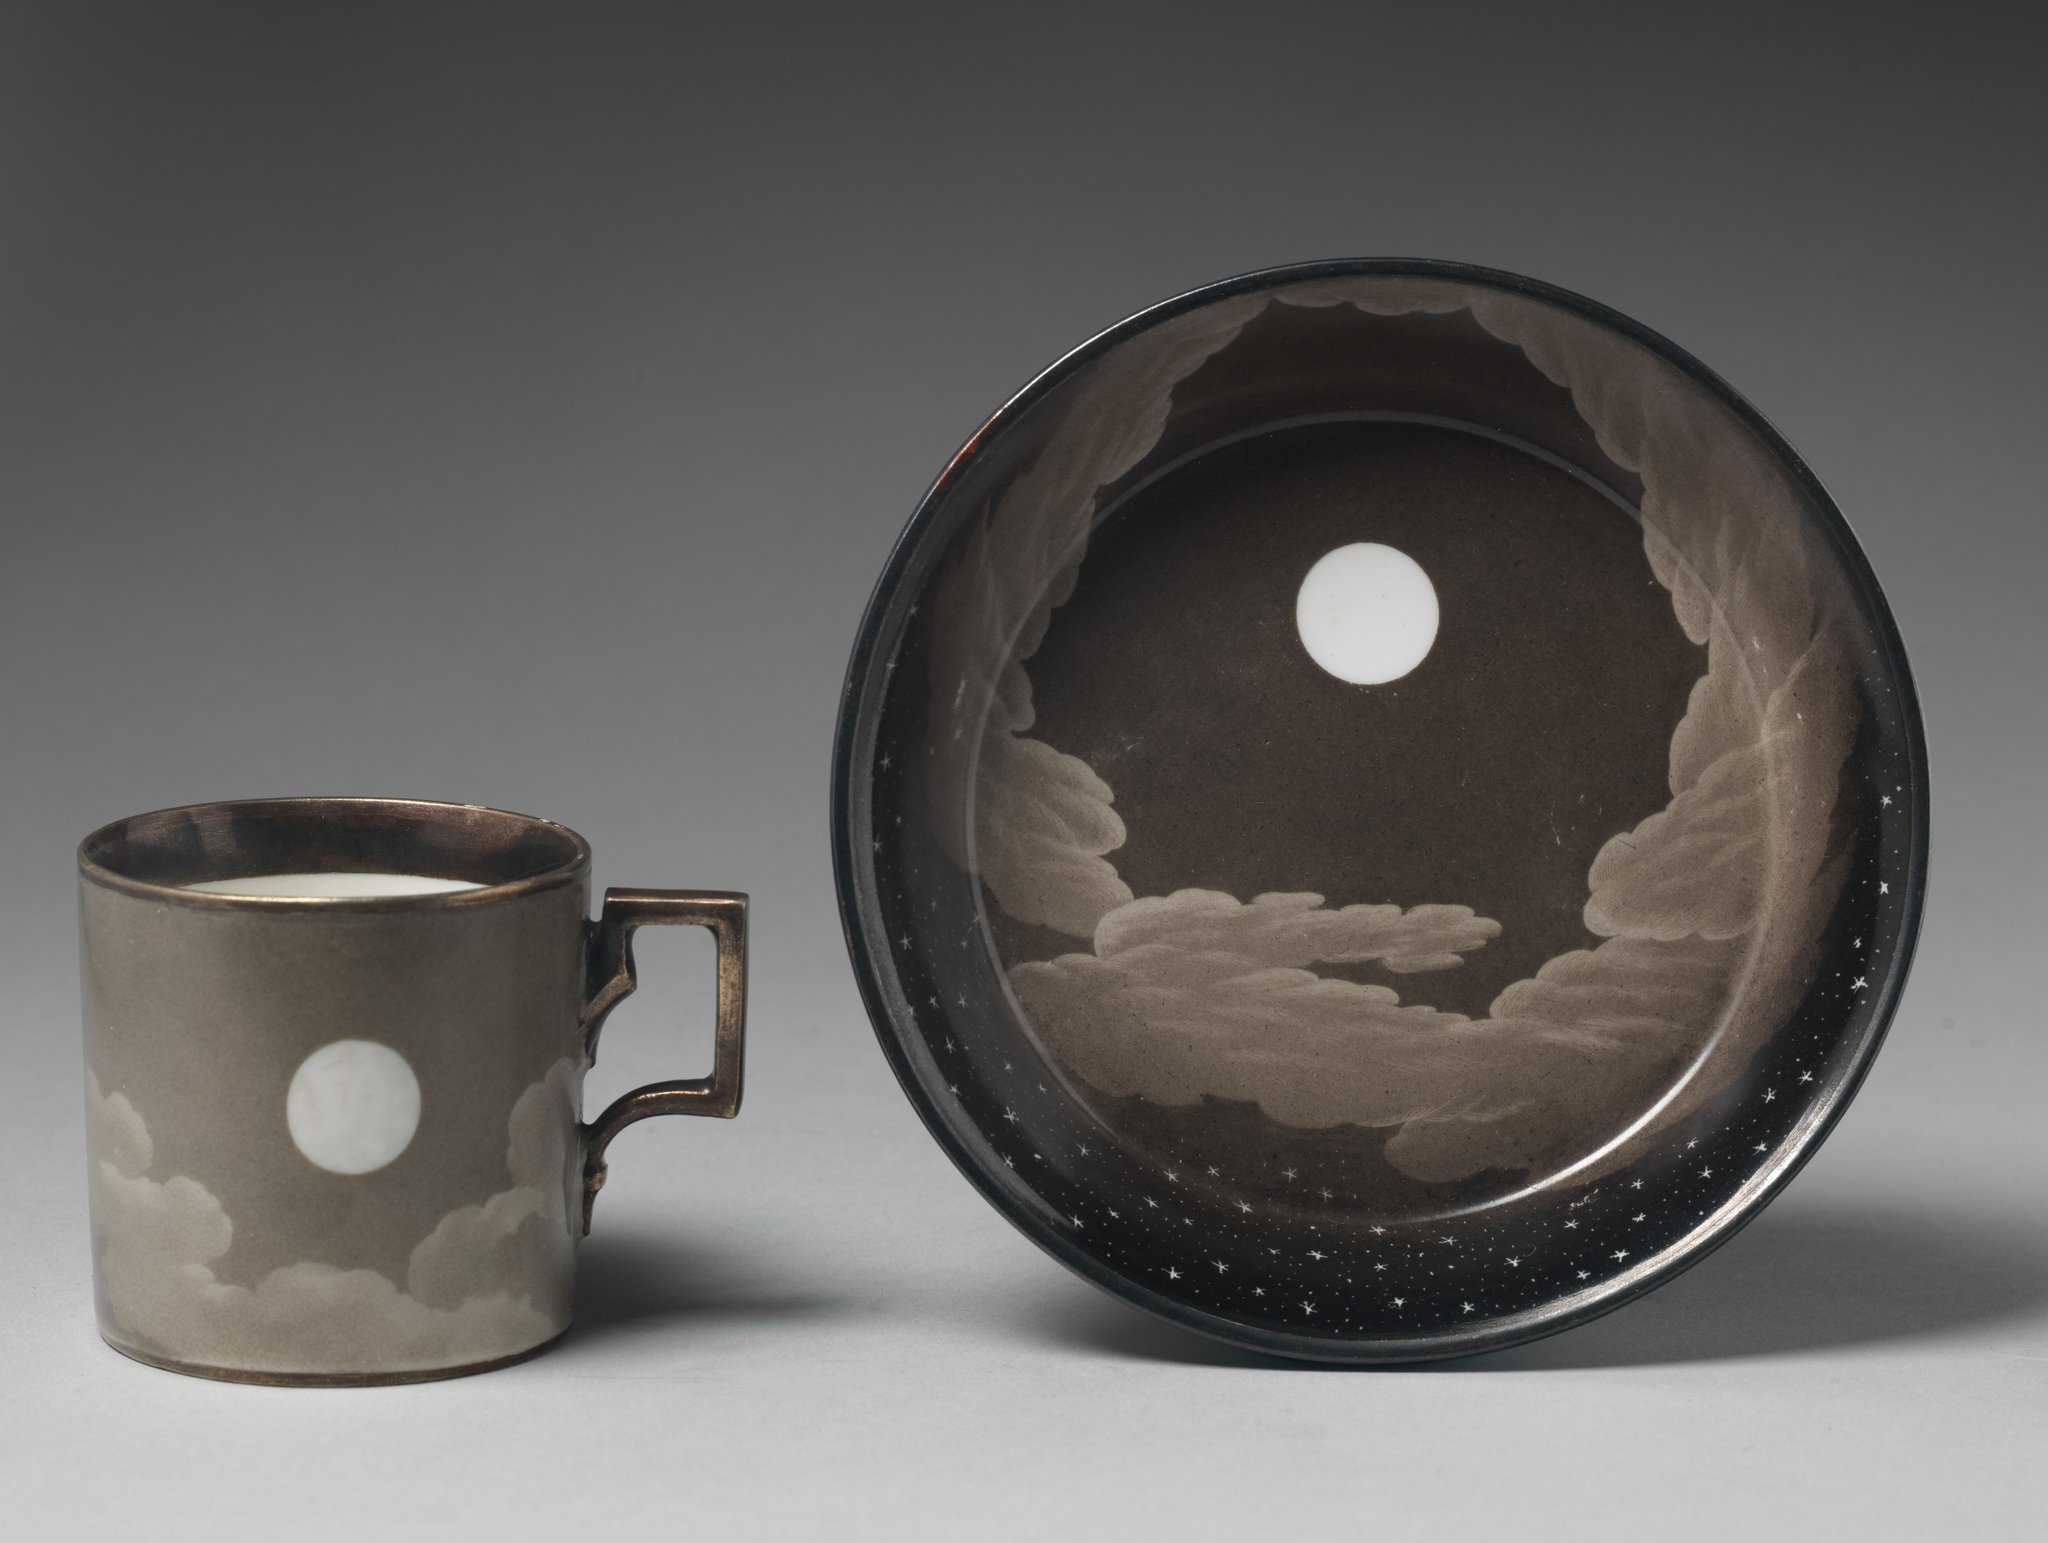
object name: cup and saucer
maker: imperial porcelain manufactory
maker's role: manufactory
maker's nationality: austrian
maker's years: 1744-1864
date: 1804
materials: porcelain